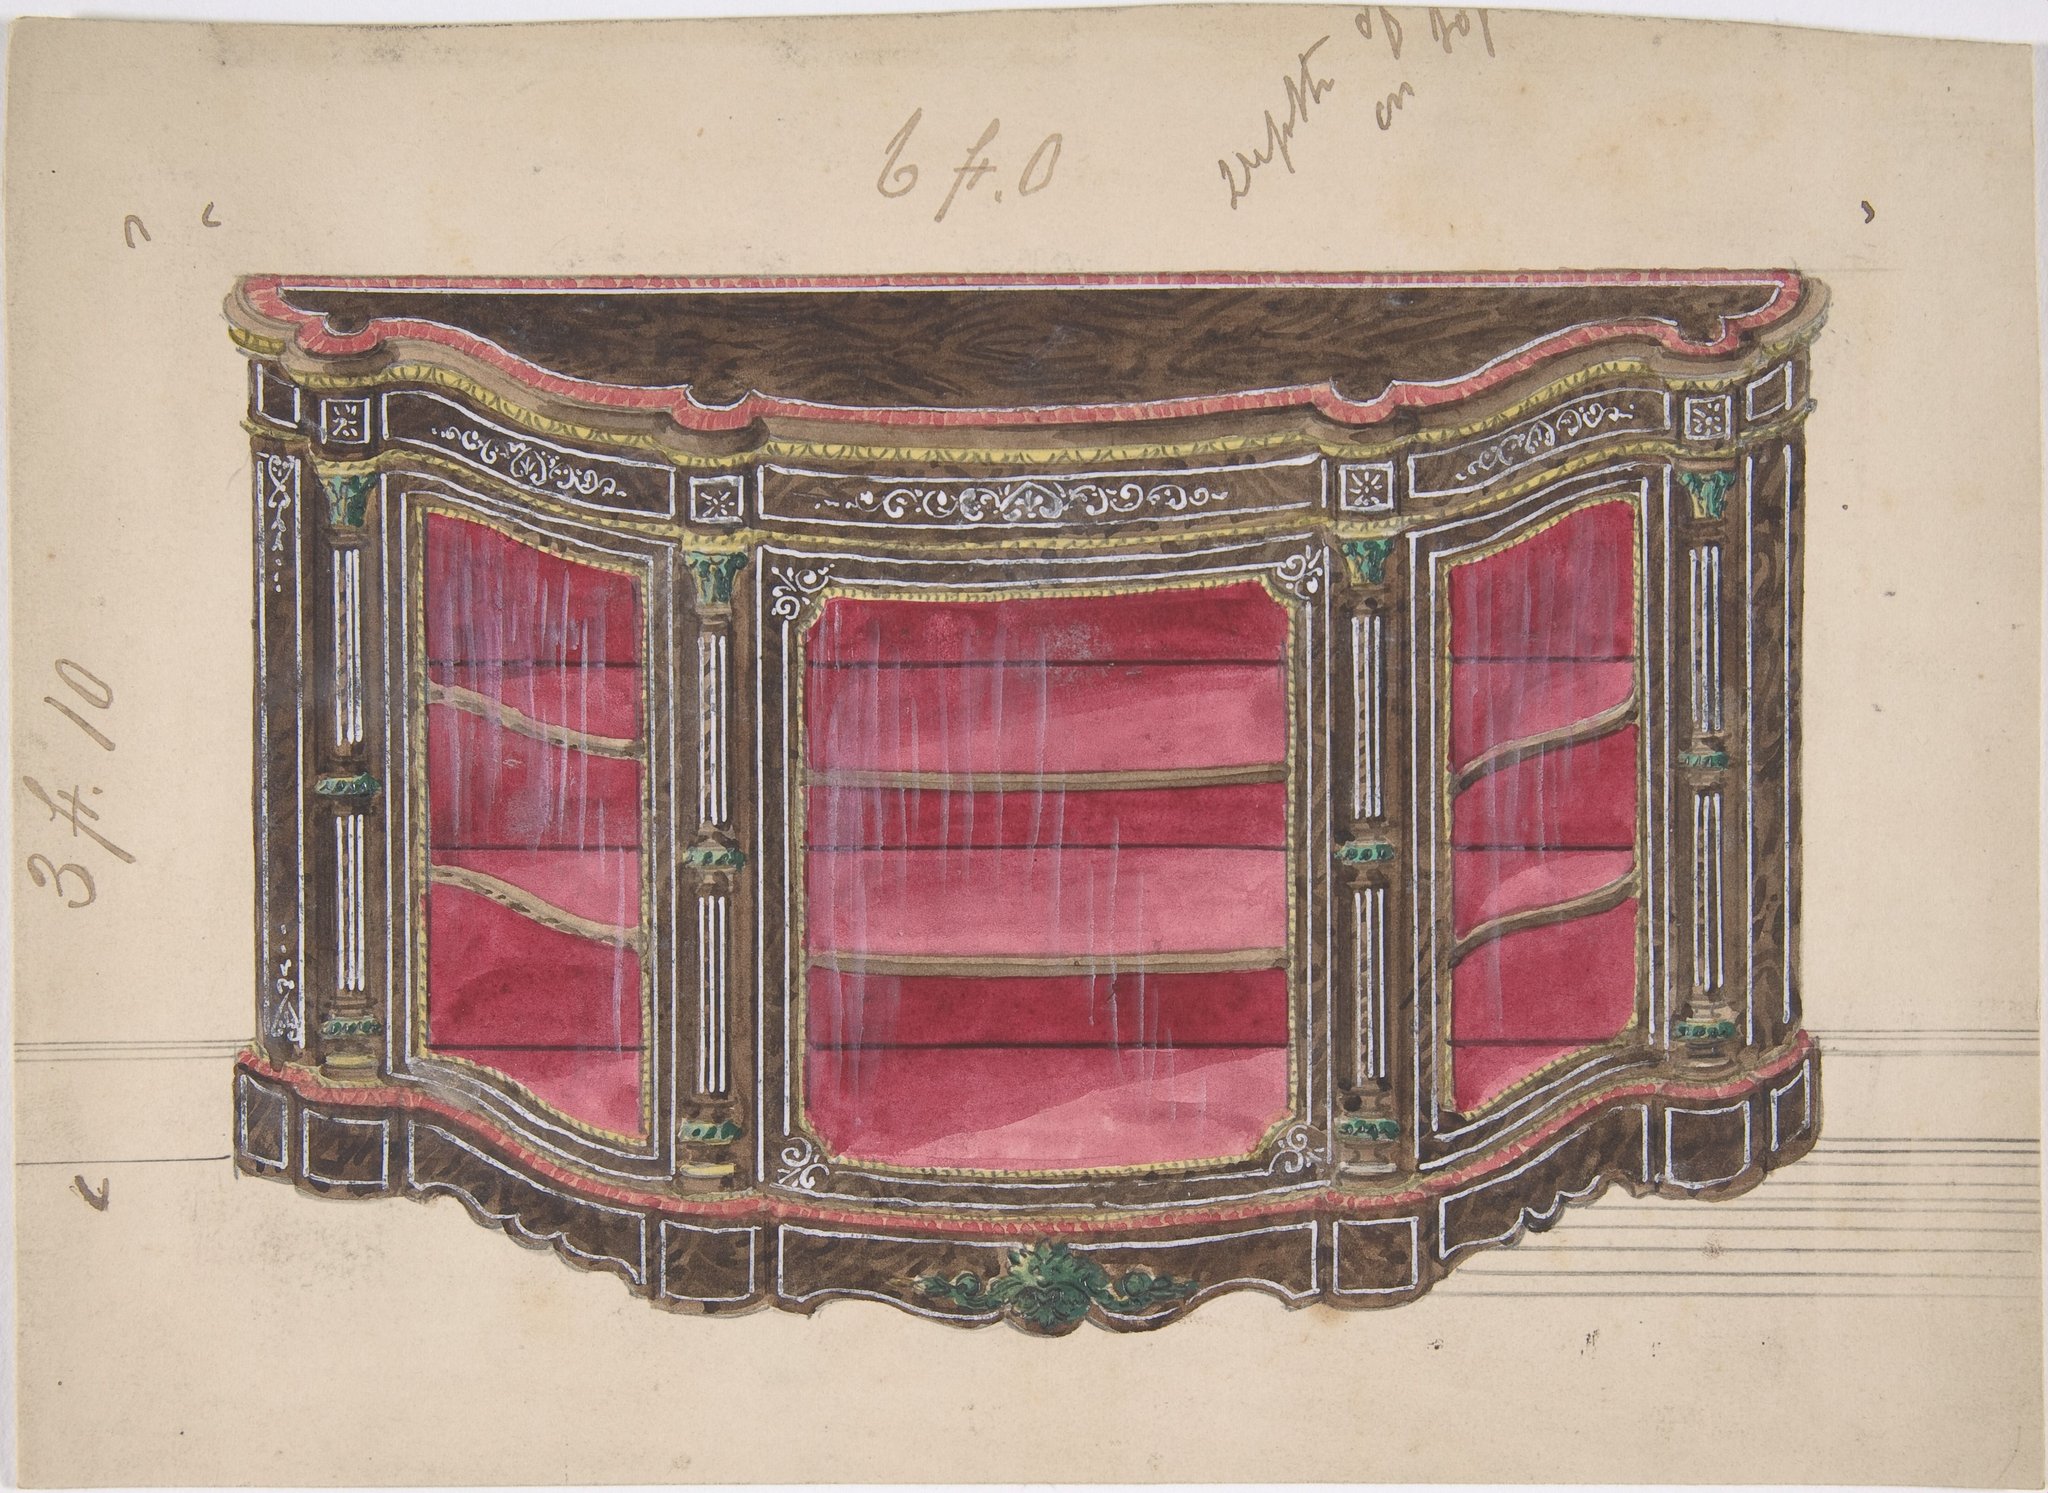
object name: drawing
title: Design for a Glass Fronted Cabinet with Red Interior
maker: anonymous, british, 19th century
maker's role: artist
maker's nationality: british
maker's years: 1800-1900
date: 1801-1900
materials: ink, watercolor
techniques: pen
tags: cabinets